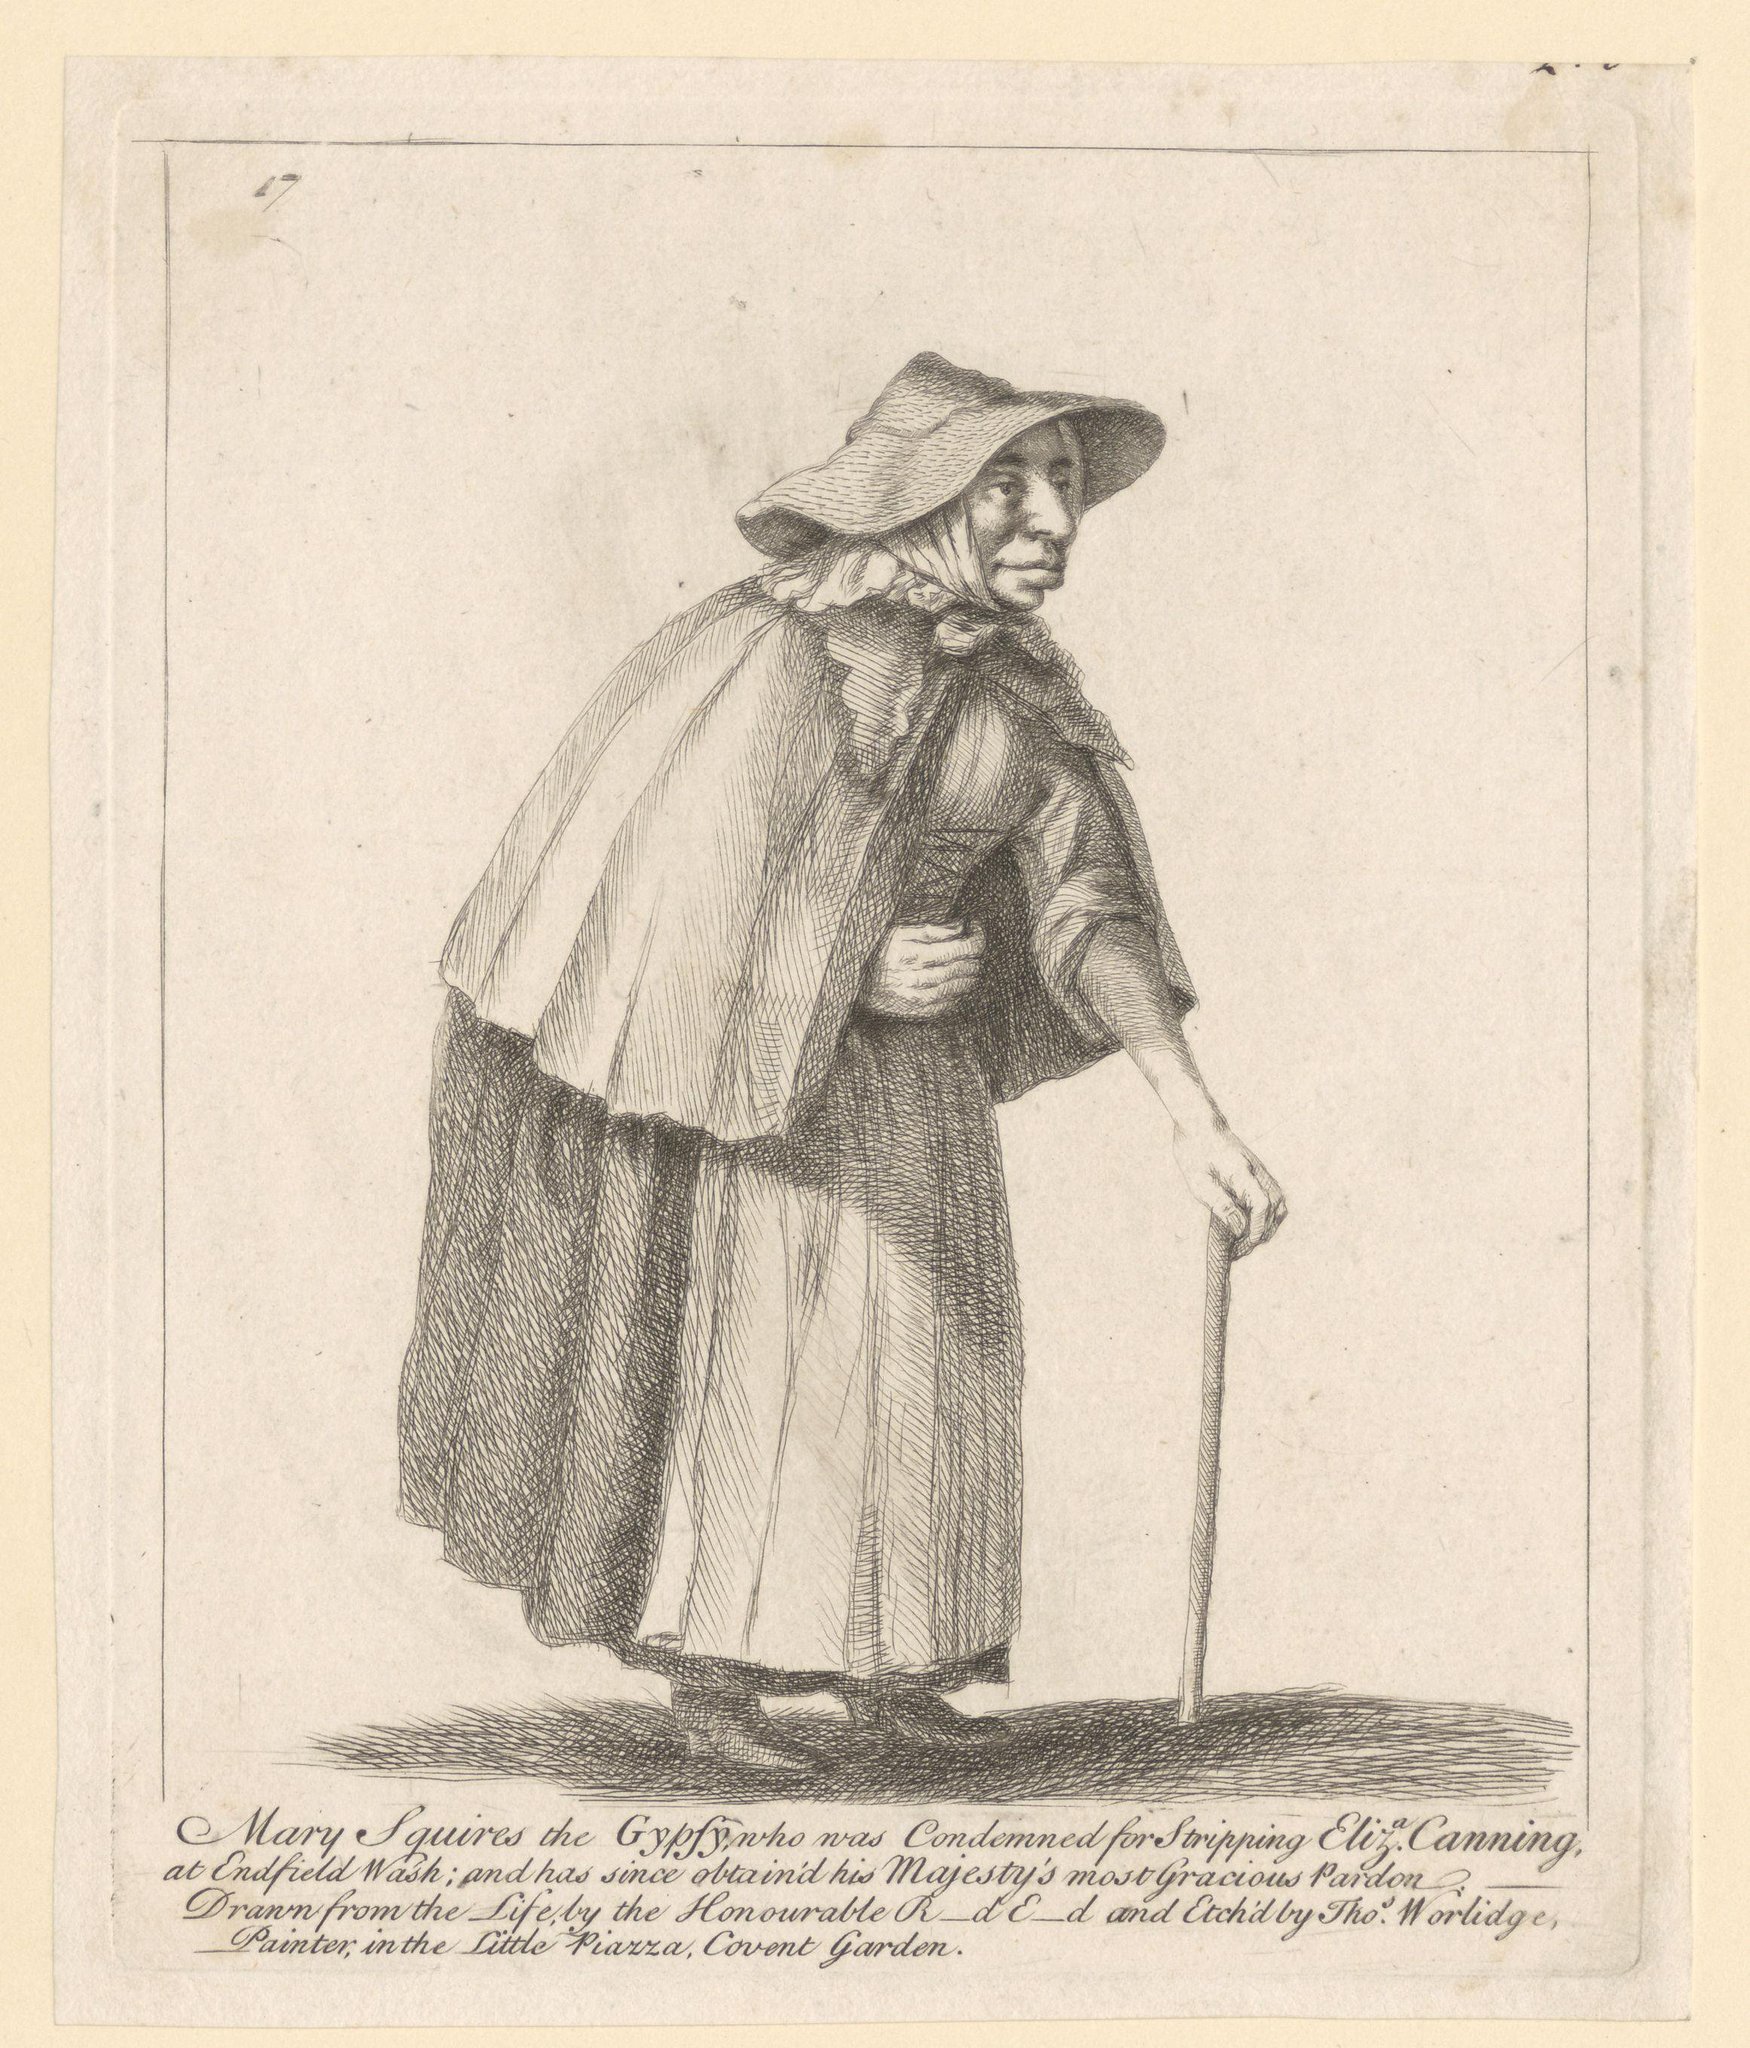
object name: print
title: Portret van Mary Squires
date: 1753-1755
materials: paper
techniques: drypoint, etching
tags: historical person (with name) - bb - woman - historical person (with name) portrayed alone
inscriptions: collector's mark: Lugt 2760, collector's mark: Lugt 2228